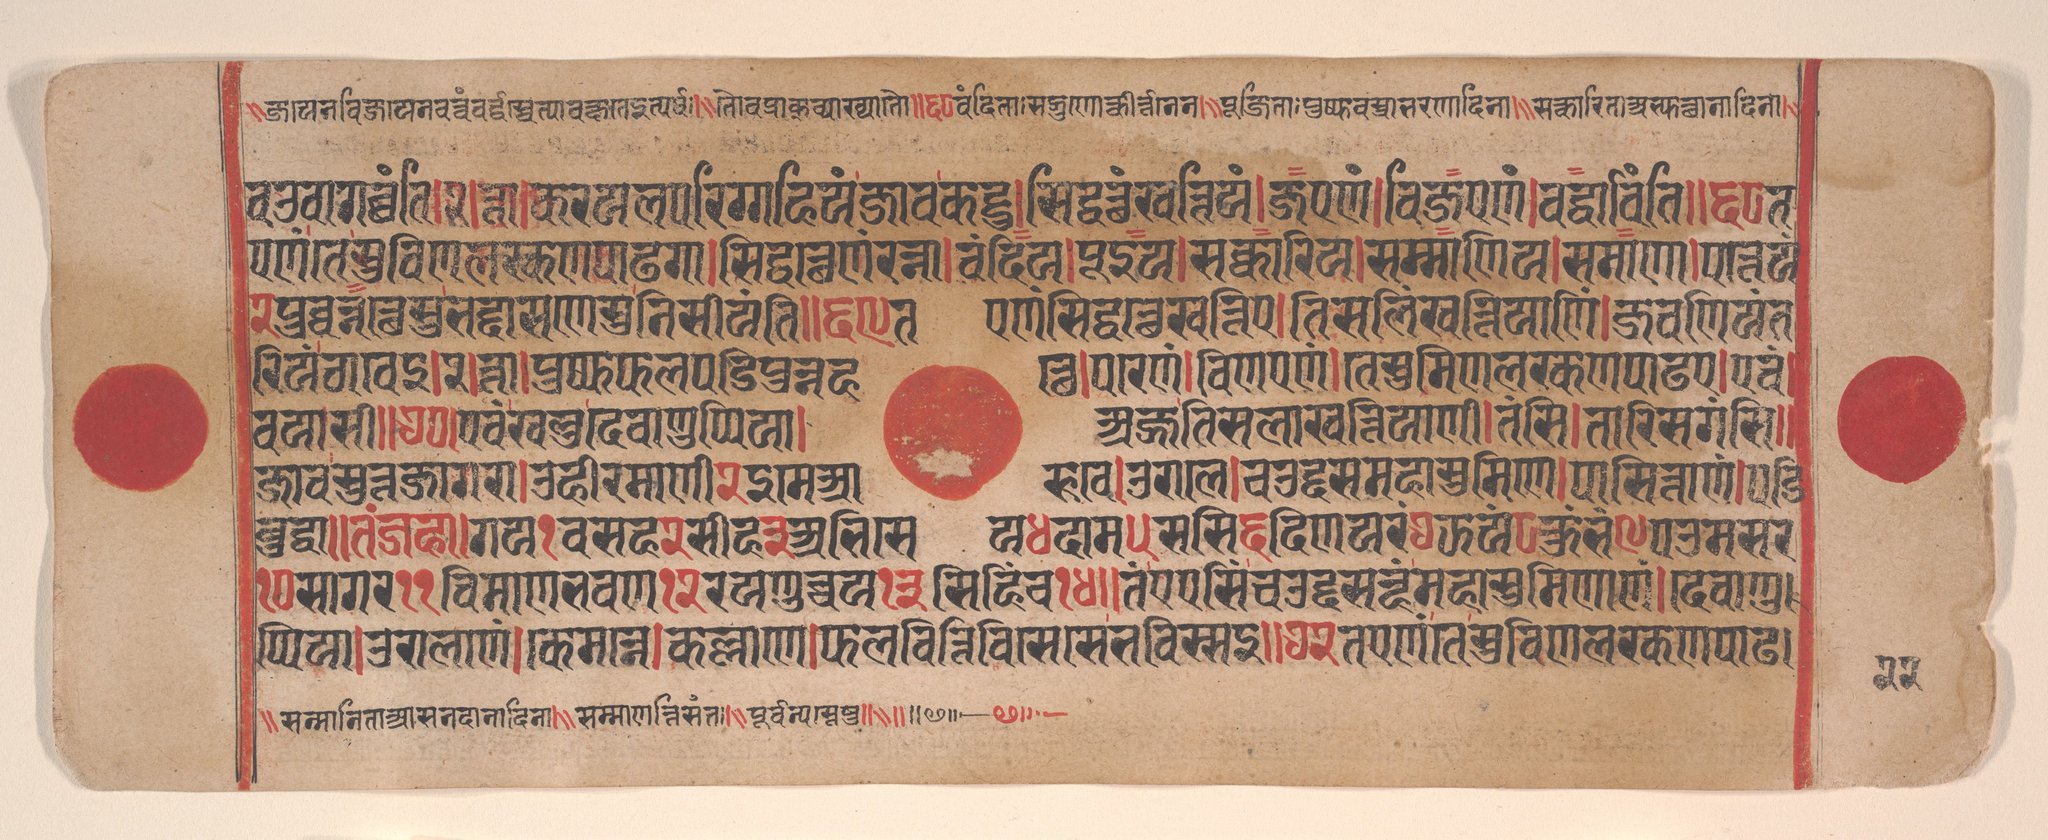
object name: folio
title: Leaf from a Kalpa Sutra (Jain Book of Rituals)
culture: indian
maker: bhadrabahu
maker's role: artist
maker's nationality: indian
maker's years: 356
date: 1401-1500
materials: gold, ink, paper, watercolor